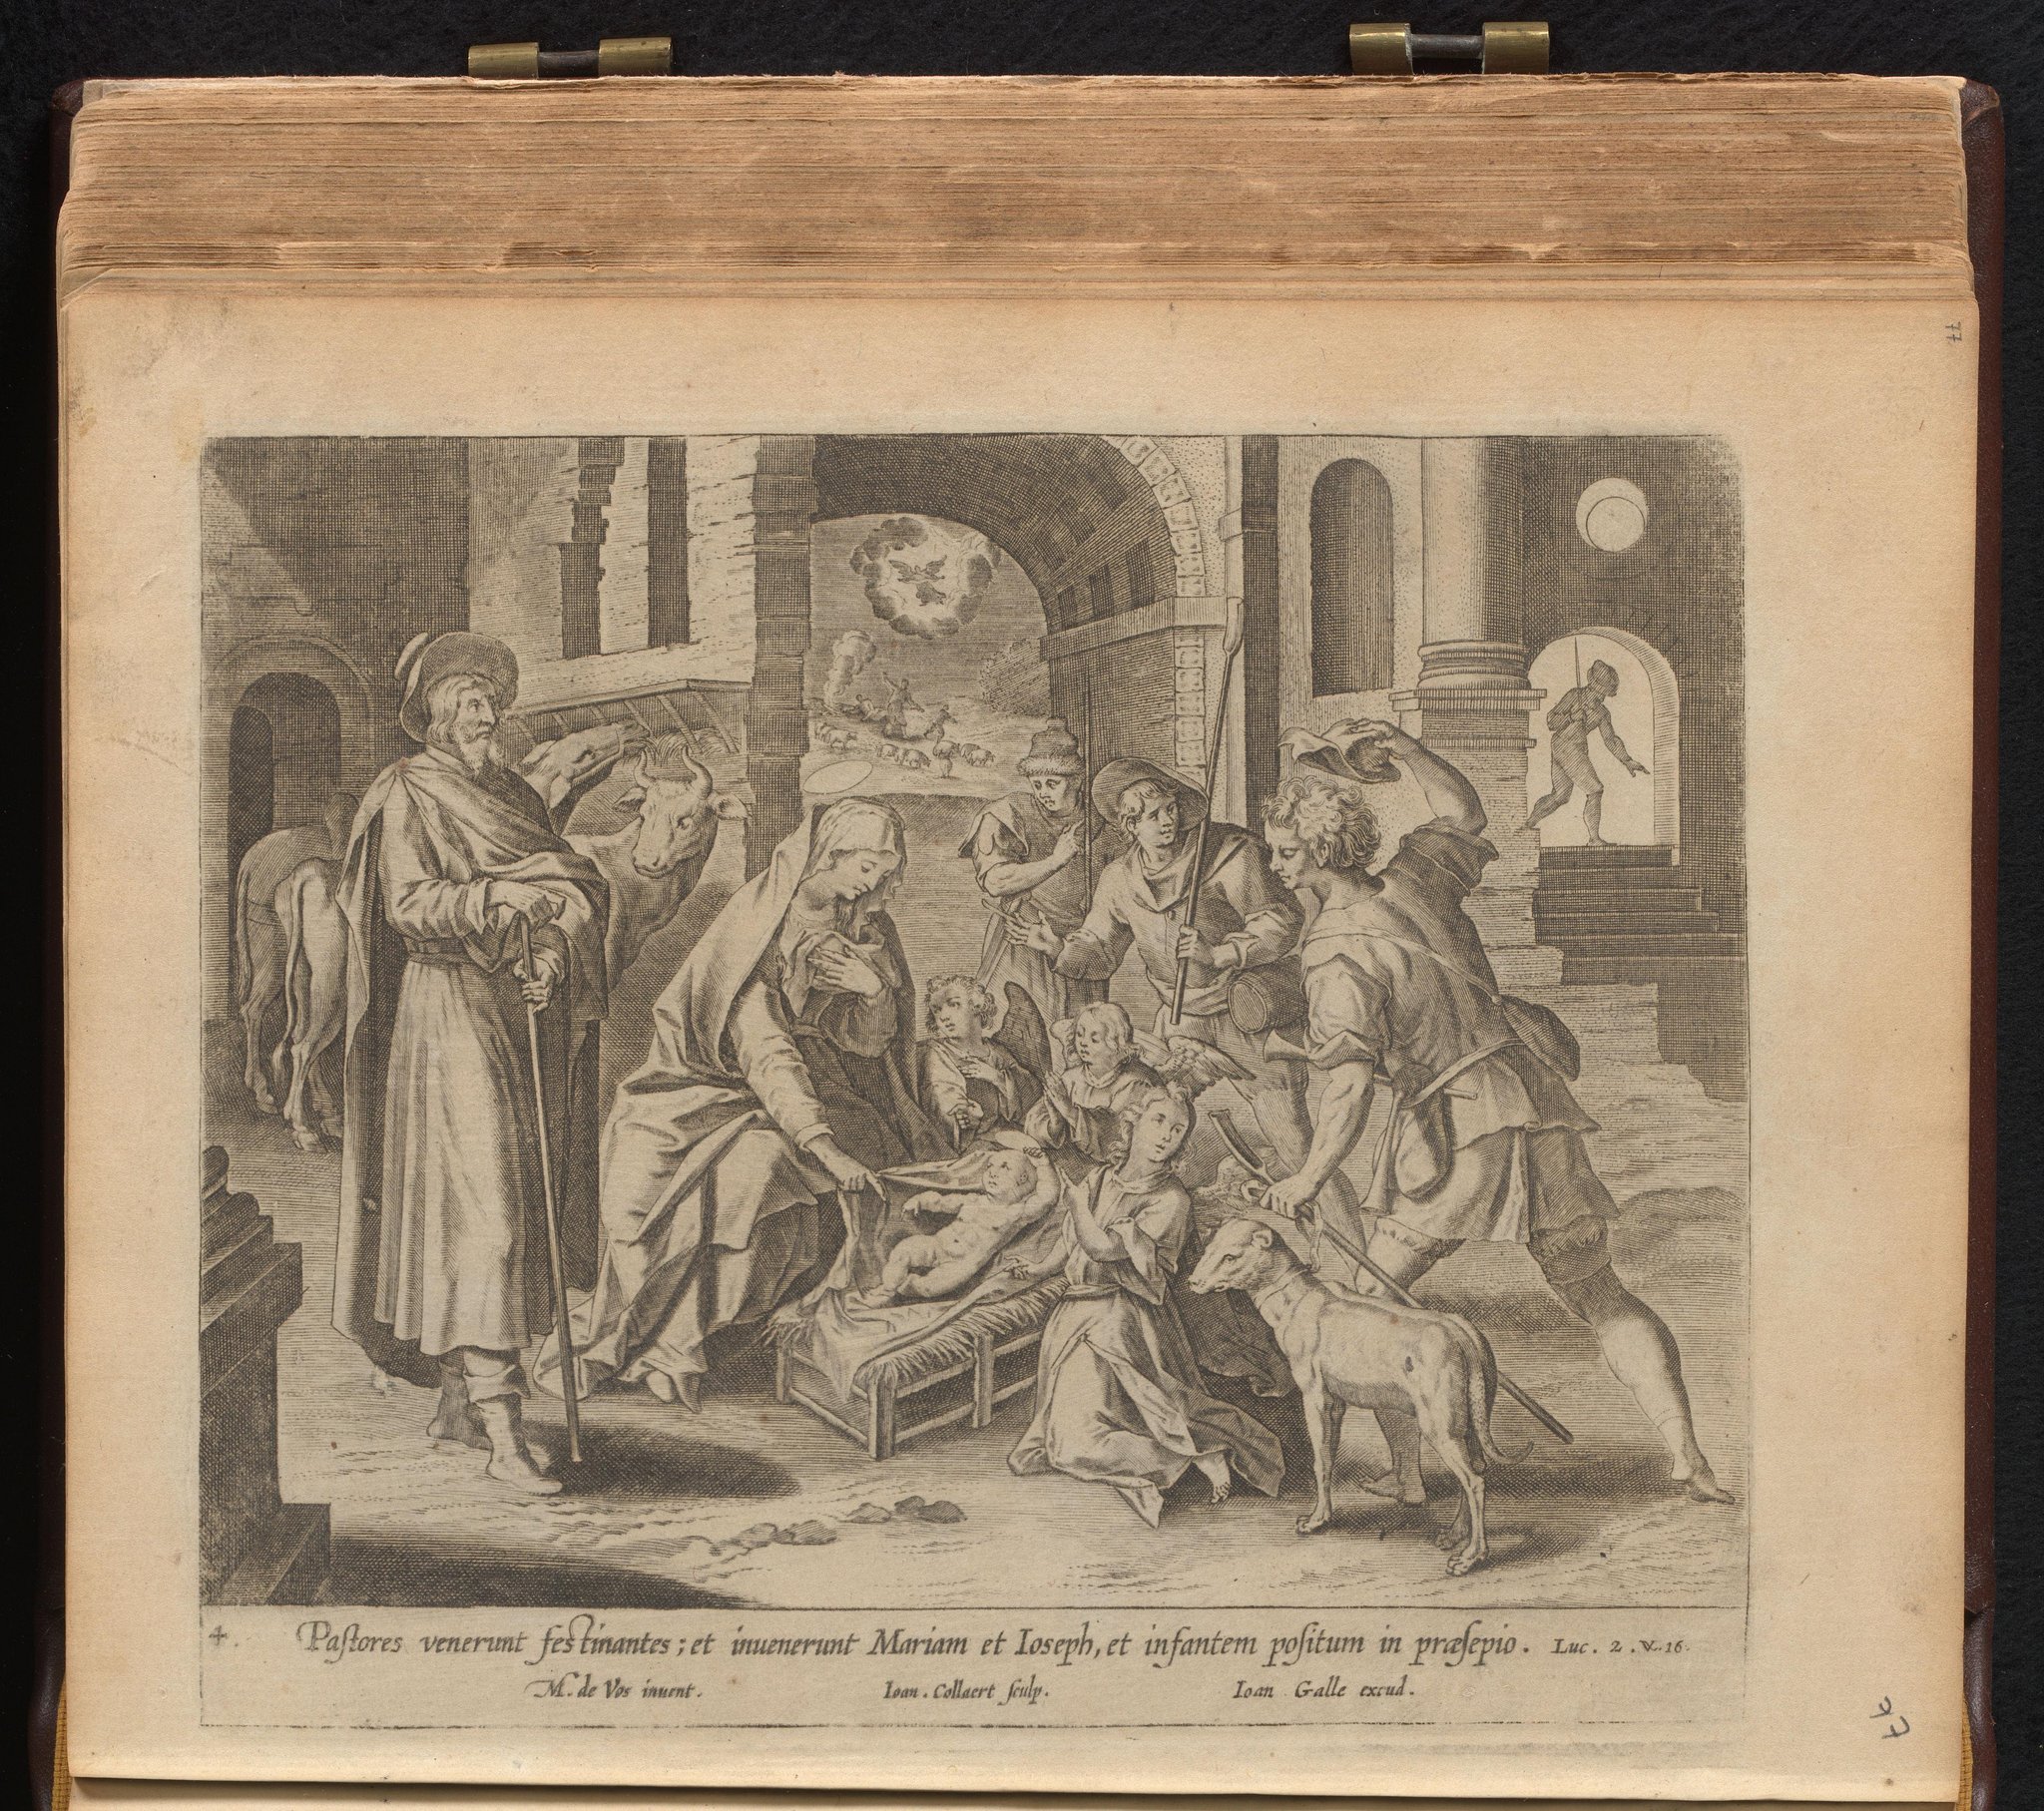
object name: print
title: Vita, passio et Resvrrectio Iesv Christi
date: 1598-1618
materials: paper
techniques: engraving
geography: antwerp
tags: adoration of the christ-child by the shepherds; mary and joseph present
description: Prent maakt deel uit van een prentbijbel.